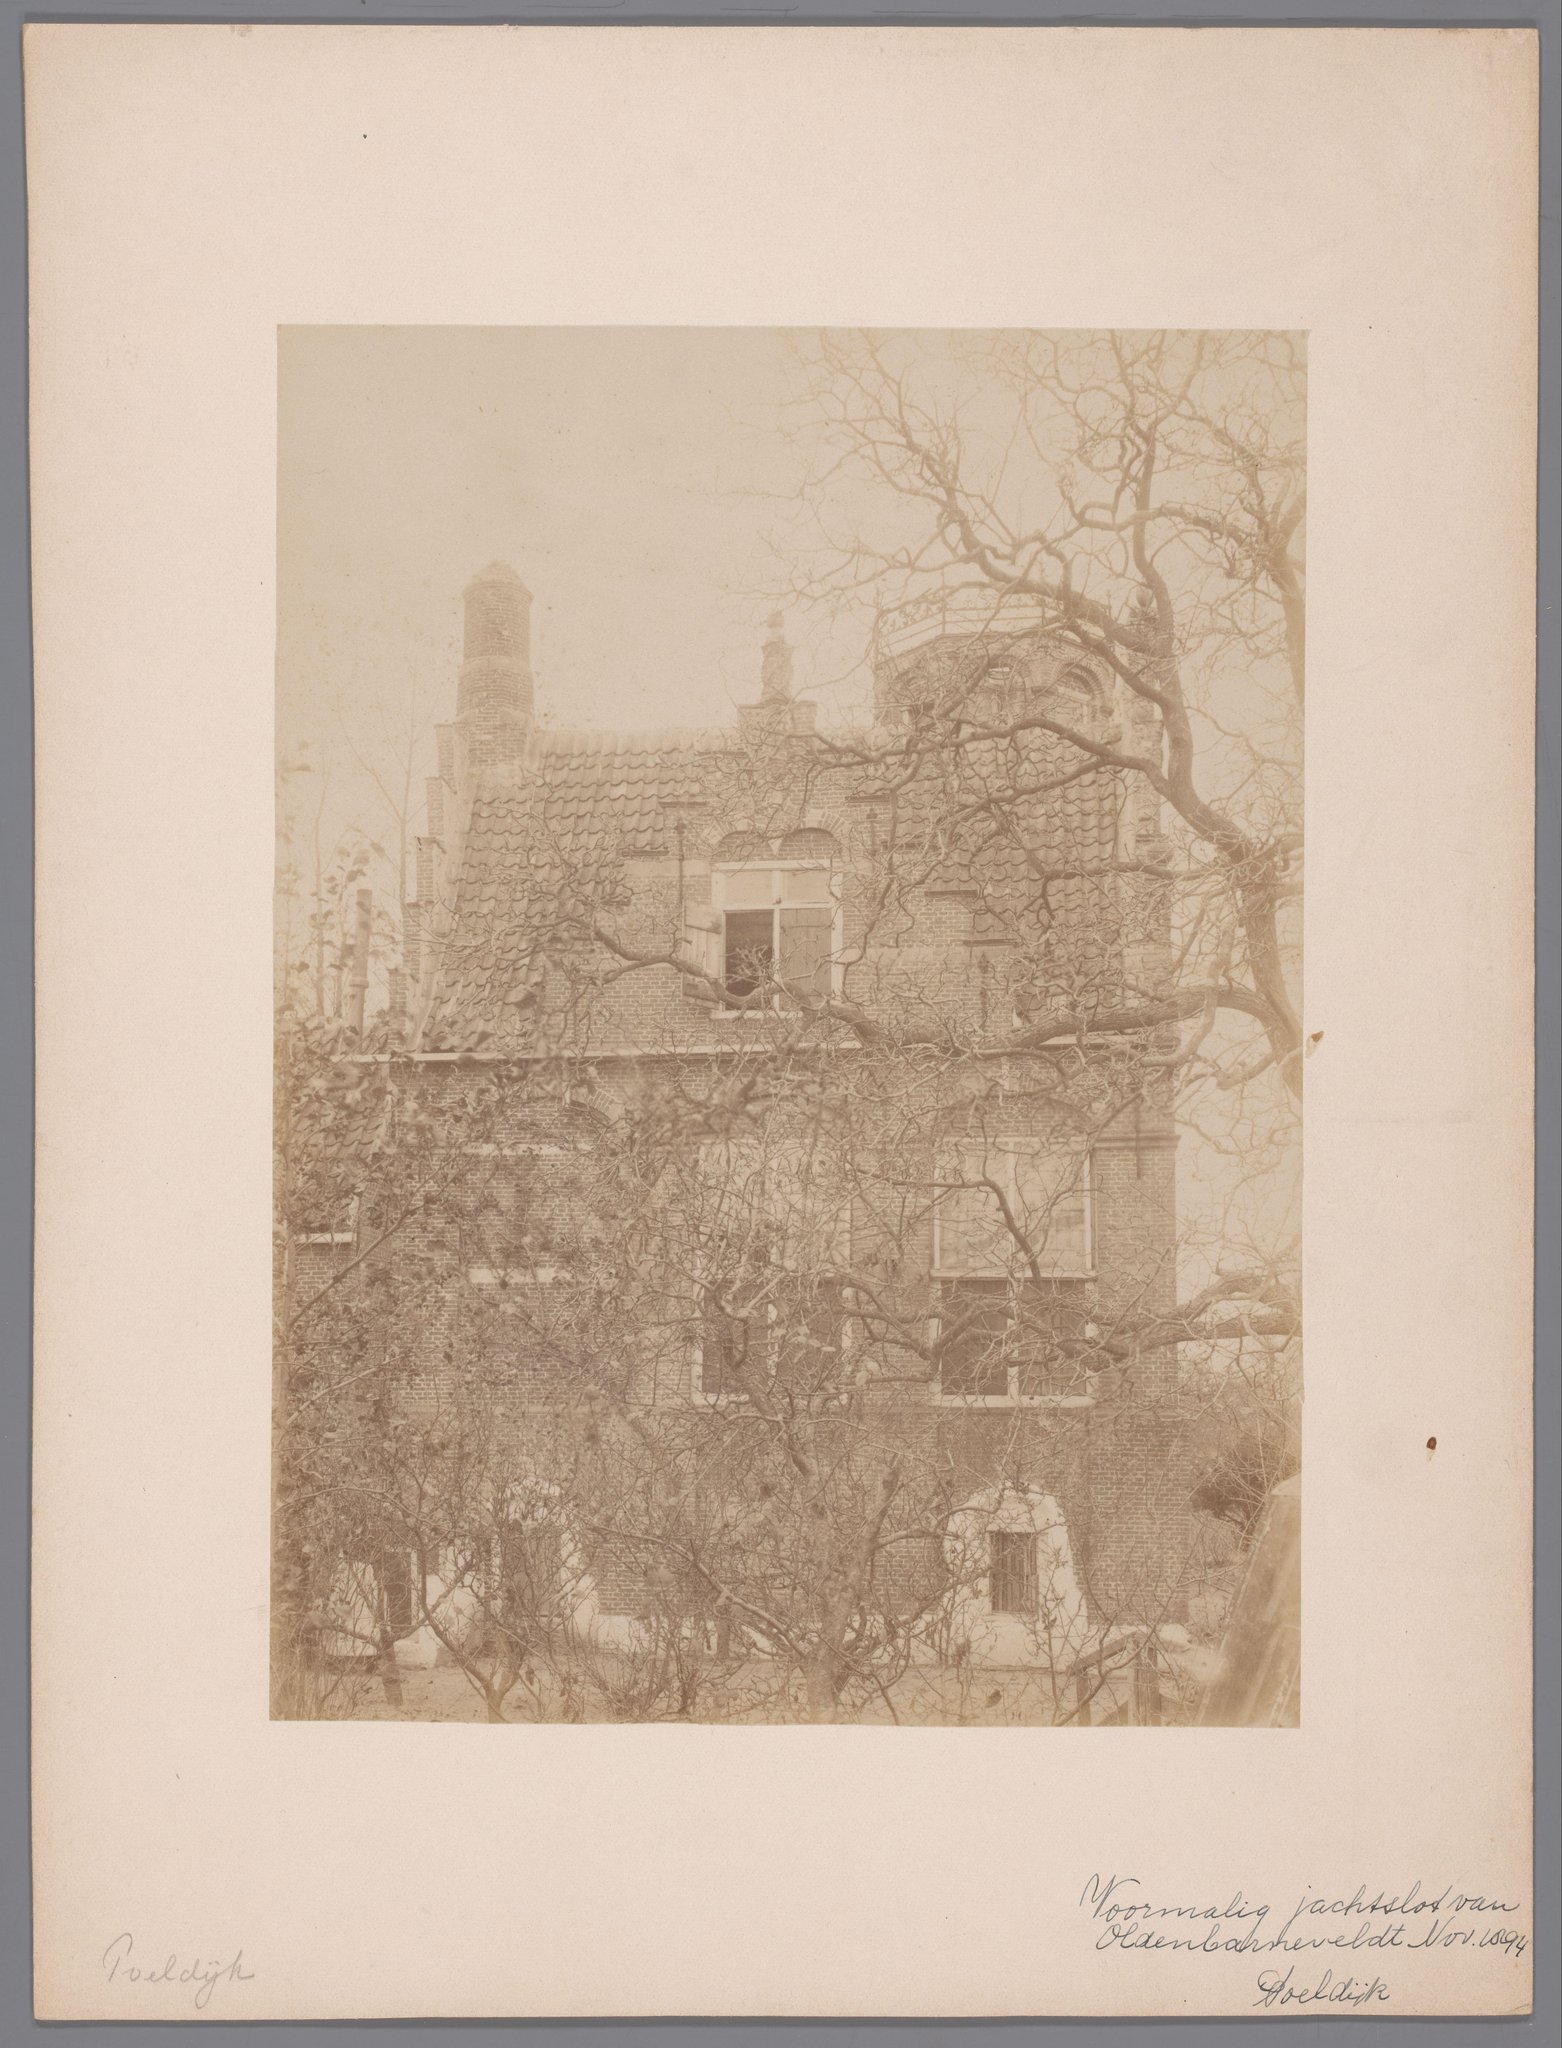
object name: photograph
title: Gezicht op het voormalige jachtslot van Oldenbarnevelt of Torenzicht te Poeldijk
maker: anoniem (monumentenzorg)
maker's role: fotograaf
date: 1904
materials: cardboard, photographic support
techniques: albumen print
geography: poeldijk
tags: castle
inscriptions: annotation: ‘Poeldijk (Z.H.)/ Torenzicht voormalig jachtslot van Oldenbarneveldt/ Nov. 1904’, annotation: ‘Voormalig jachtslot van Oldenbarneveldt/ Nov. 1894 Poeldijk’